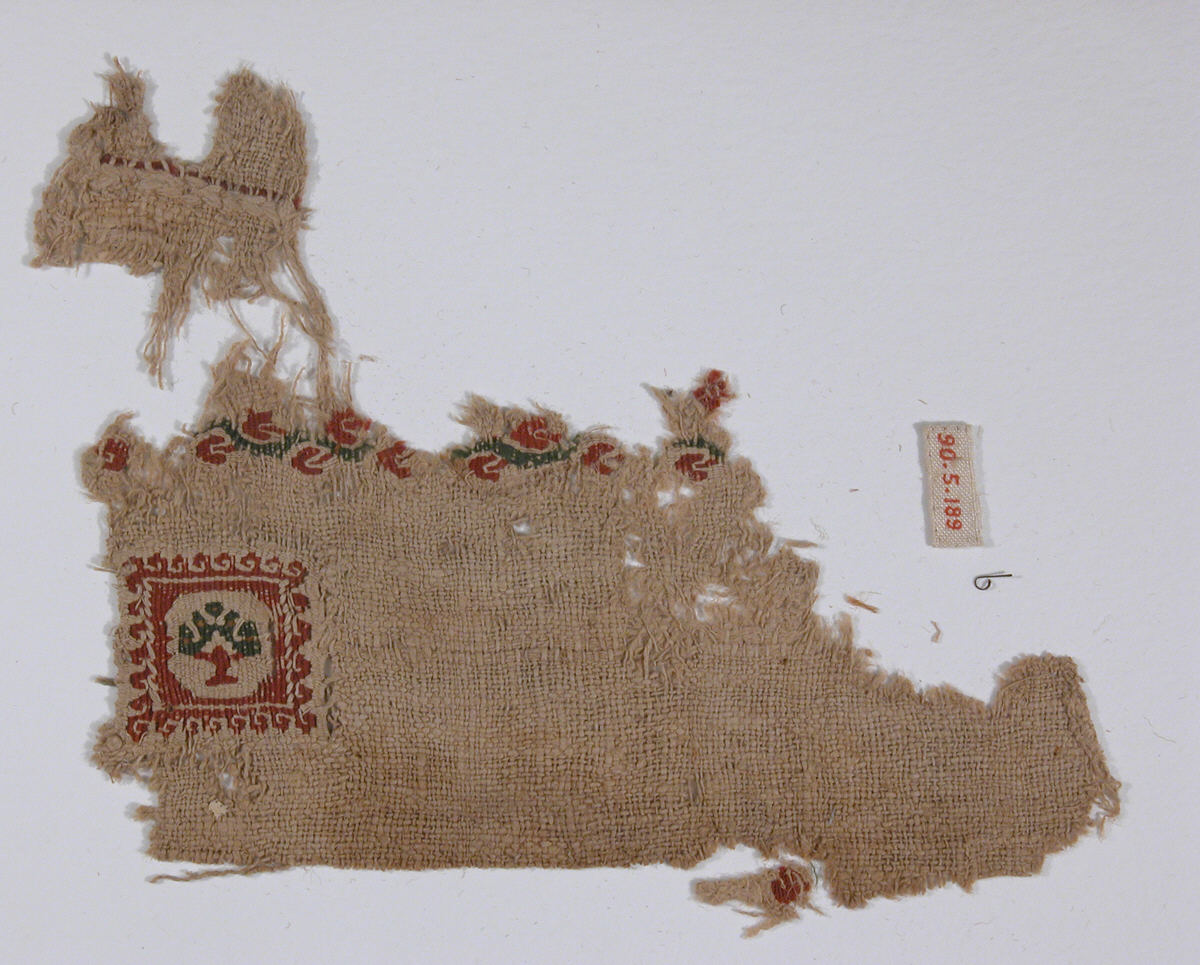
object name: textile fragment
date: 401-500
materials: linen, wool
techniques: weave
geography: egypt